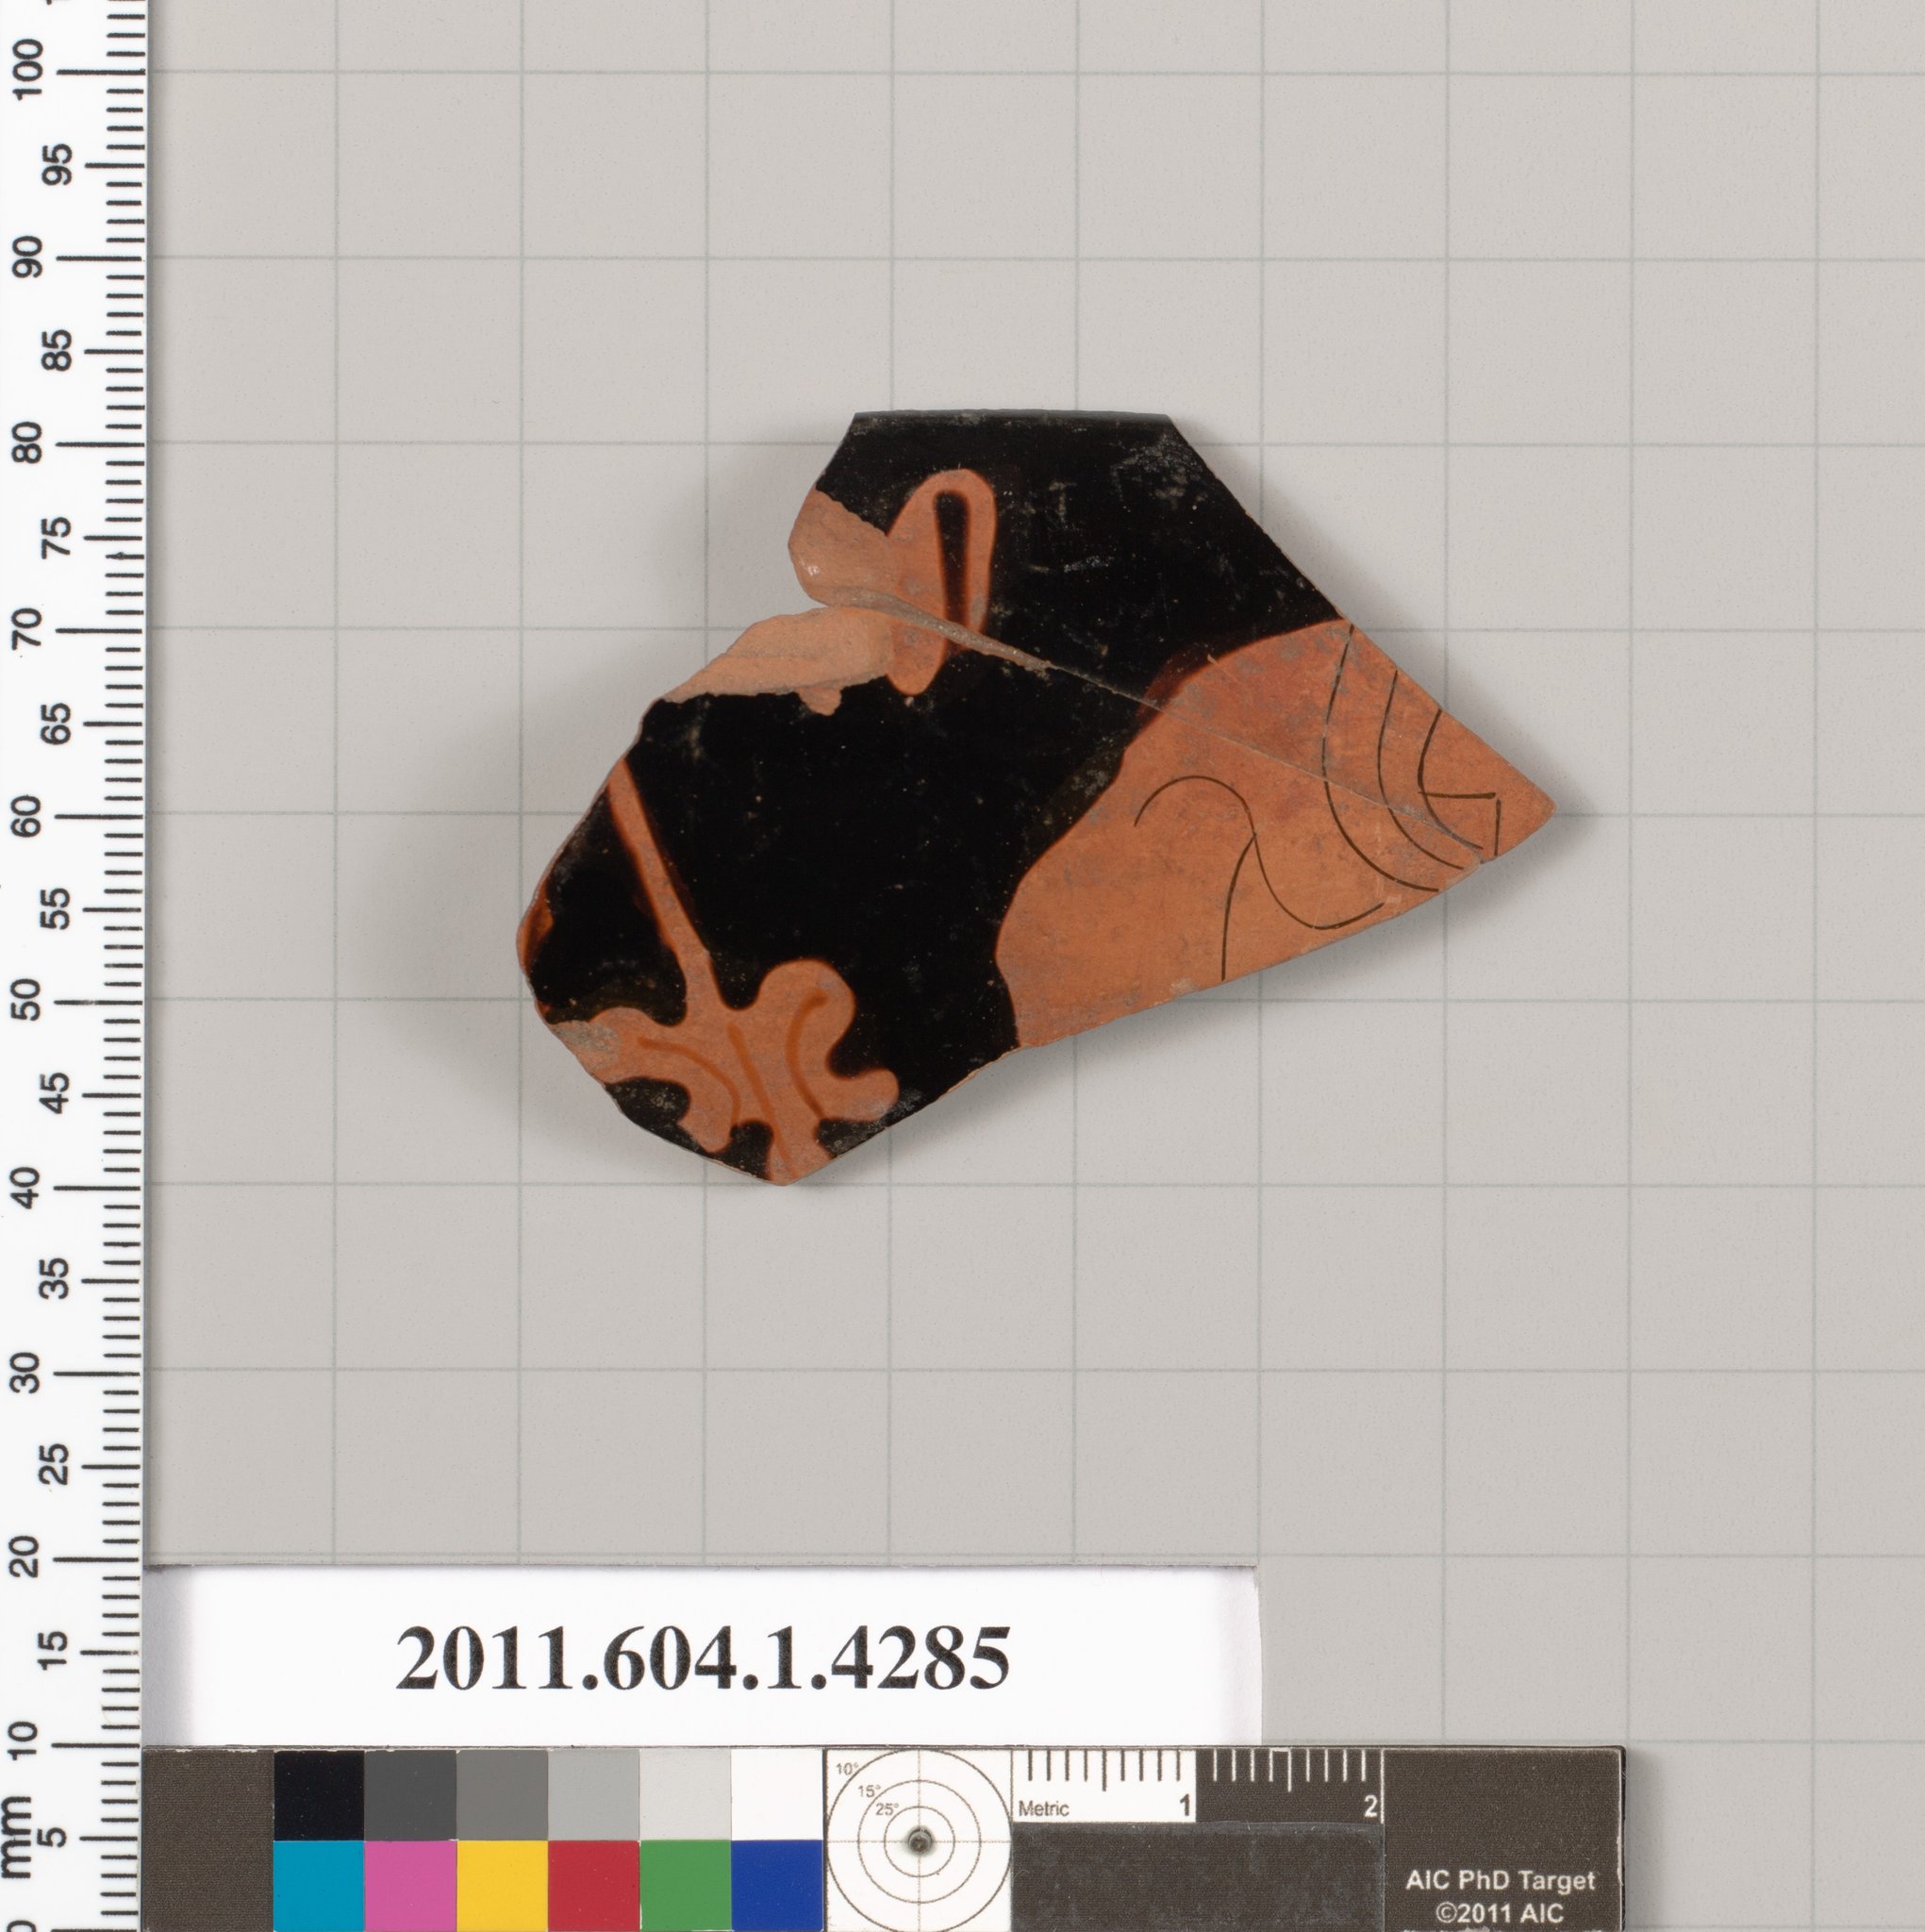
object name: kylix fragment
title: Terracotta rim fragment of a kylix (drinking cup)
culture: greek, attic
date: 475-451 BCE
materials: terracotta